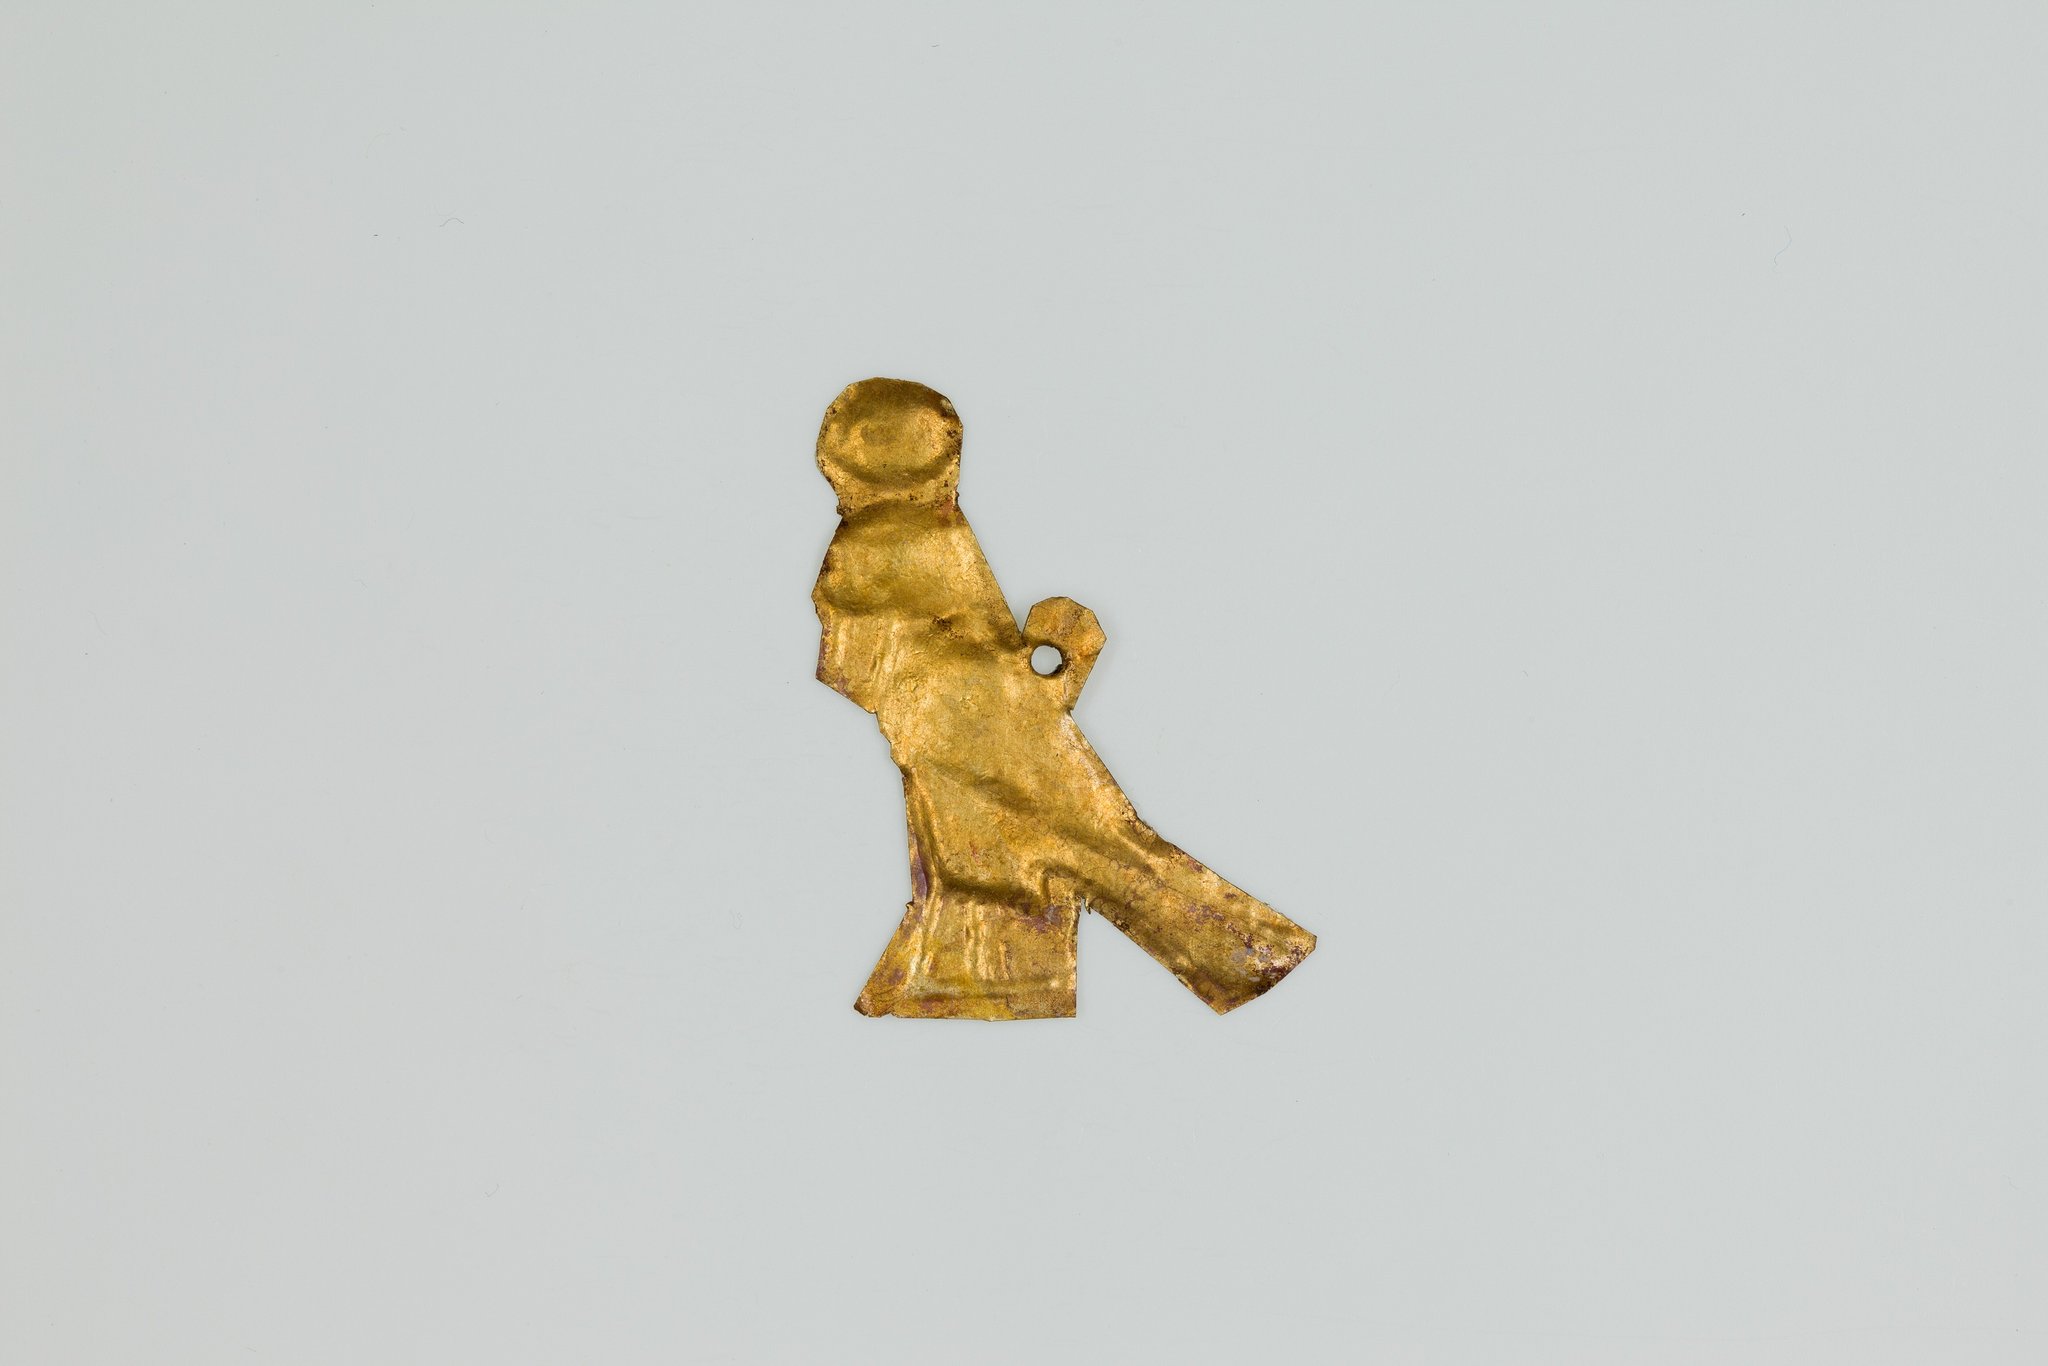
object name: amulet, ba bird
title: Ba-bird with sun disk amulet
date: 664-380 BCE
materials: gold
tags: birds